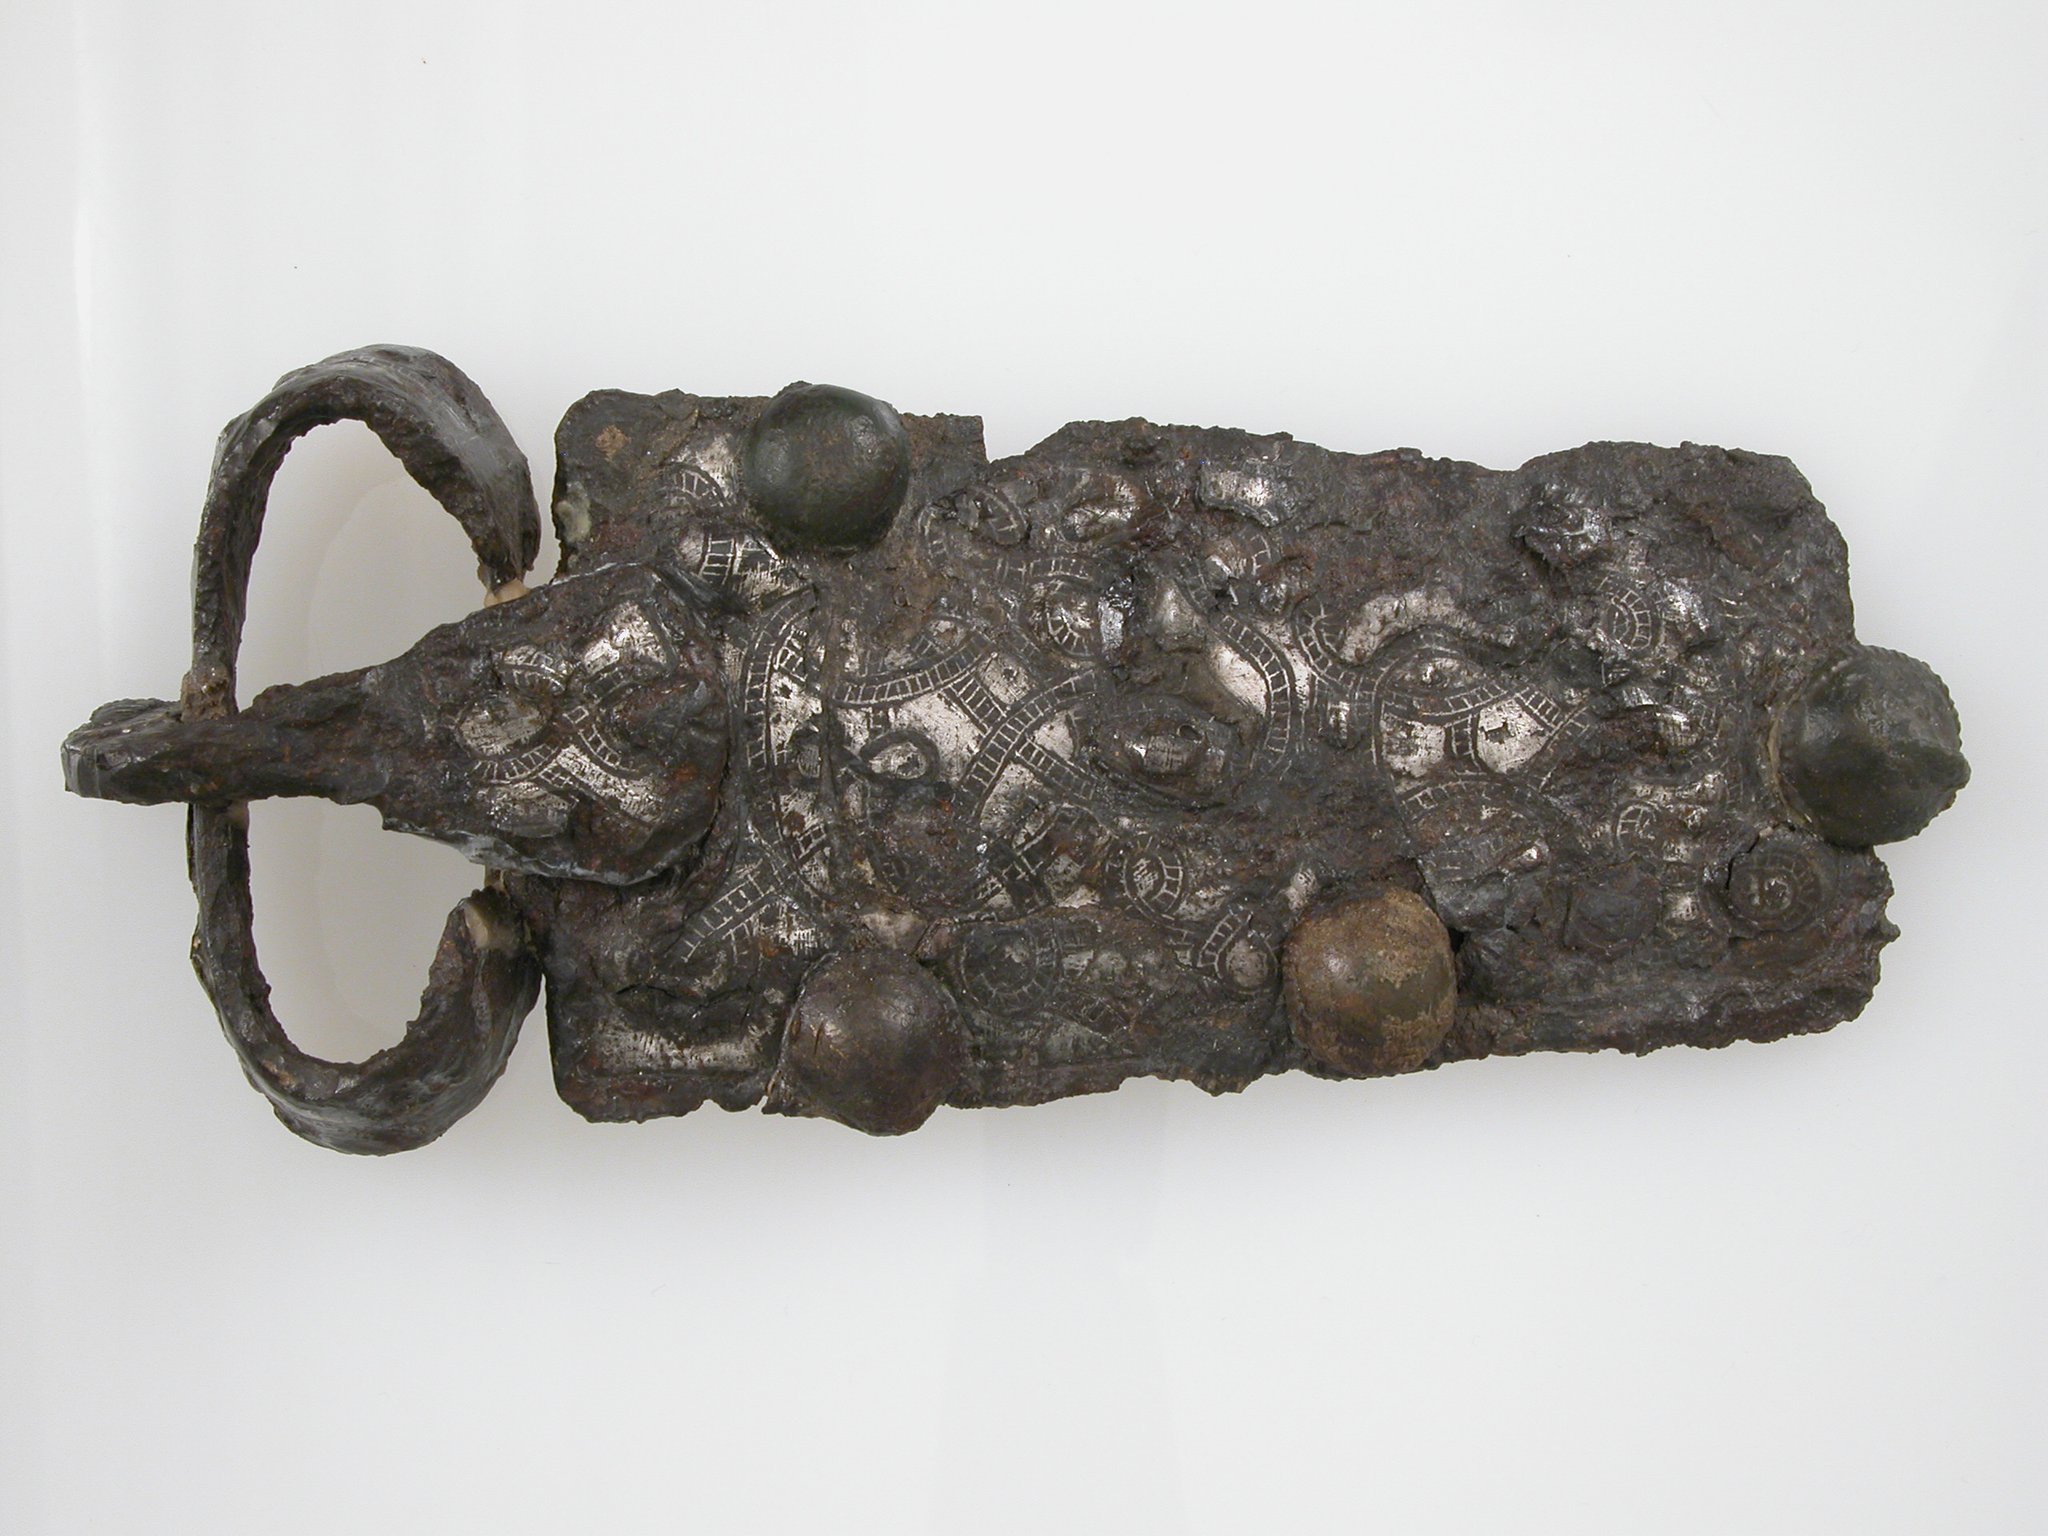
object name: belt buckle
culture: burgundian or frankish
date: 501-700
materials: bronze, iron, silver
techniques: inlay